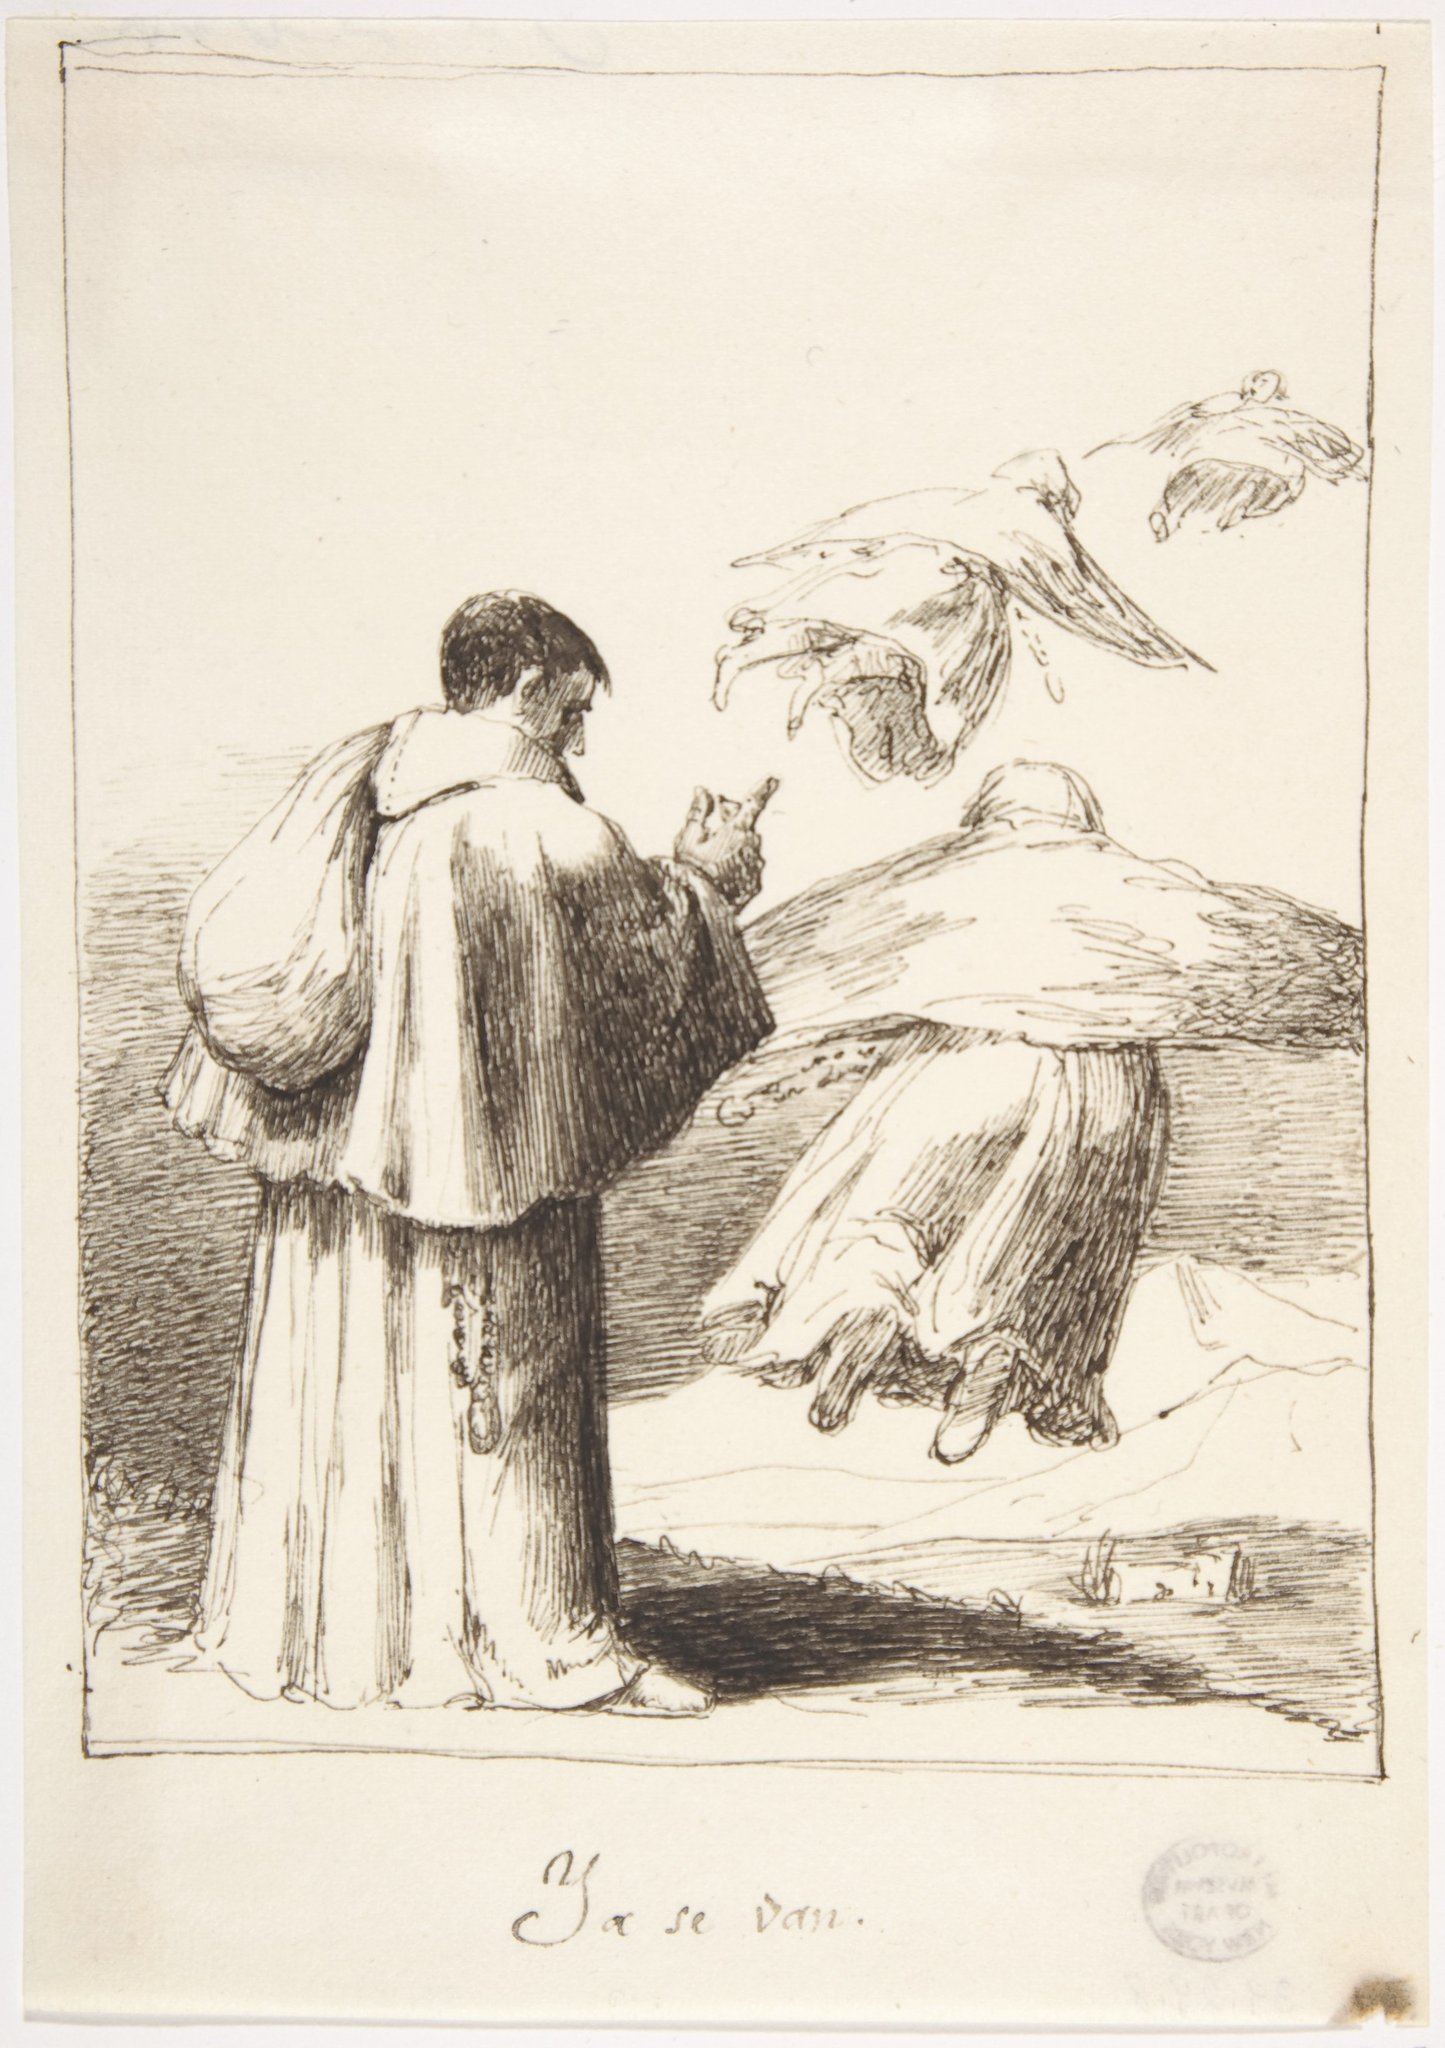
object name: drawing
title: Already They Are Going (Ya se van)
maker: leonardo alenza y nieto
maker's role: artist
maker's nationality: spanish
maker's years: 1807-1845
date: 1807-1845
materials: ink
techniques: pen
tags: men